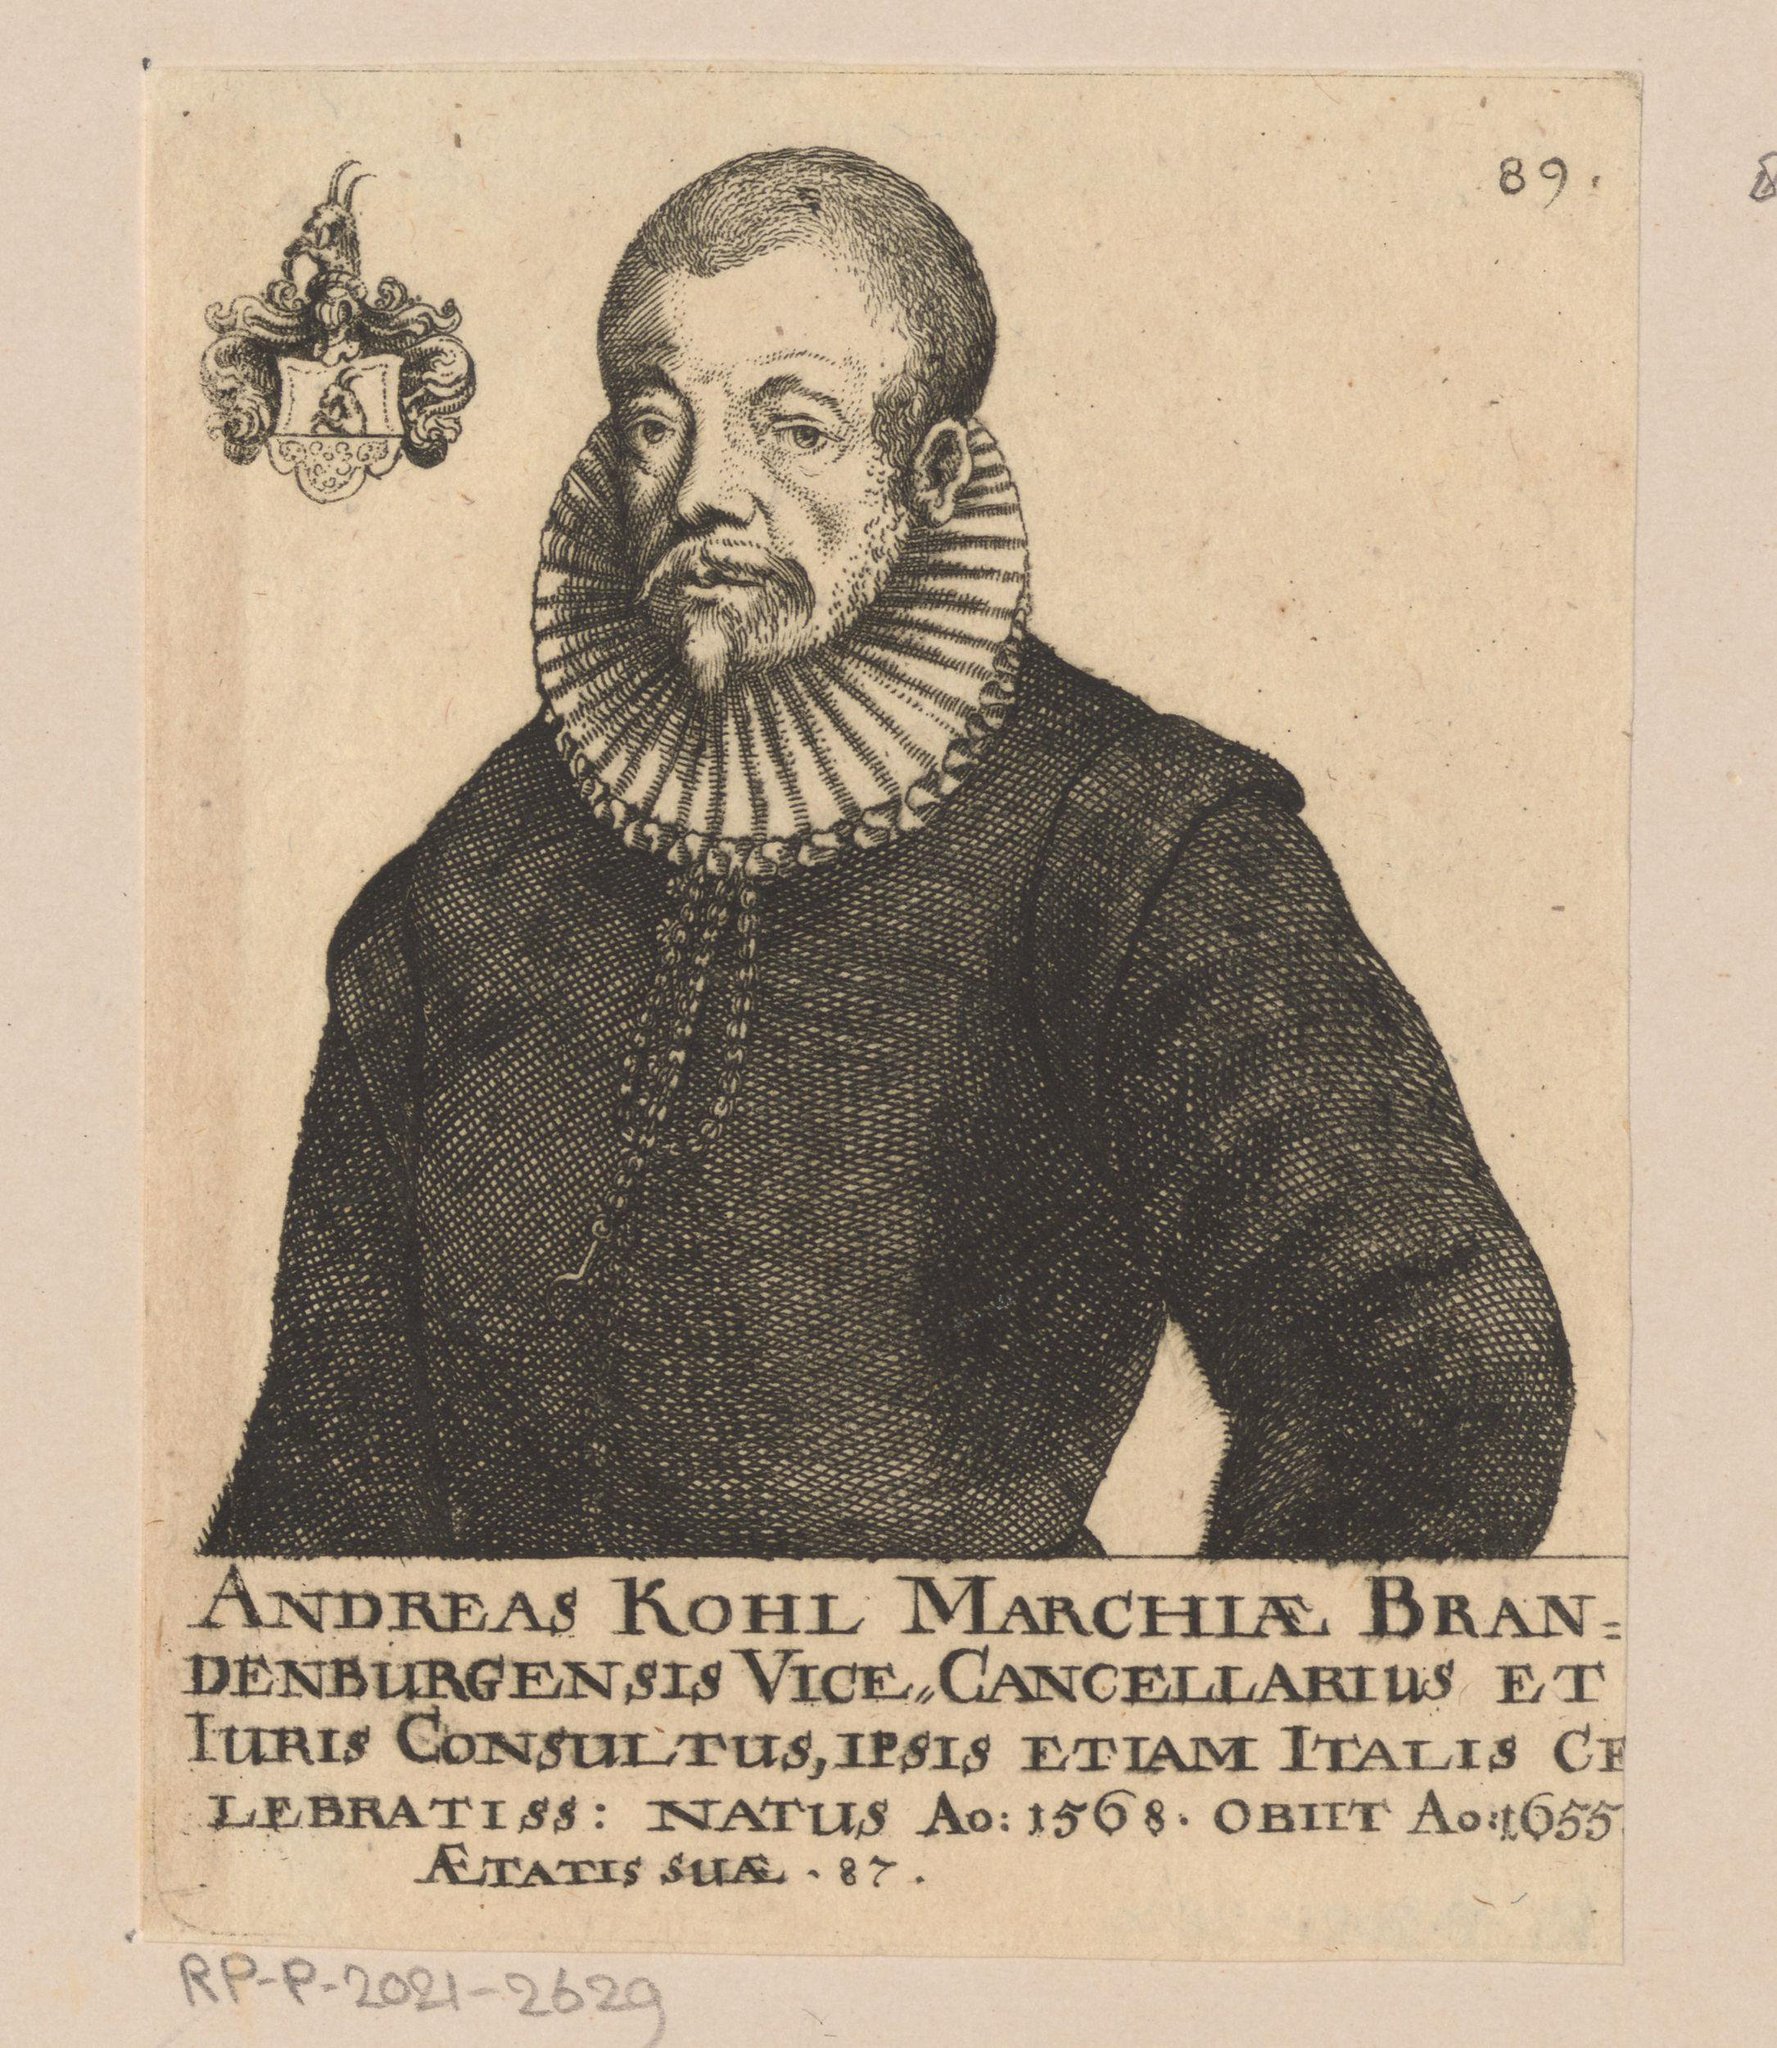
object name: print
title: Icones et elogia virorum aliquot praestantium (...)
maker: Anonymous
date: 1751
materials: paper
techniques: etching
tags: print maker, andreas kohl, historical persons, armorial bearing, heraldry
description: De prent is uitgegeven als onderdeel van een serie. Later is de prent ook als boekillustratie gebruikt in: Küster, Georg Gottfried. Martin Friedrich Seidels Bilder-Sammlung in welcher hundert, gröstentheils in der Mark Brandenburg (…). Berlijn: Buchladen bey der Real-Schule, 1751. Het is onduidelijk tot welke uitgave de huidige prent behoort.